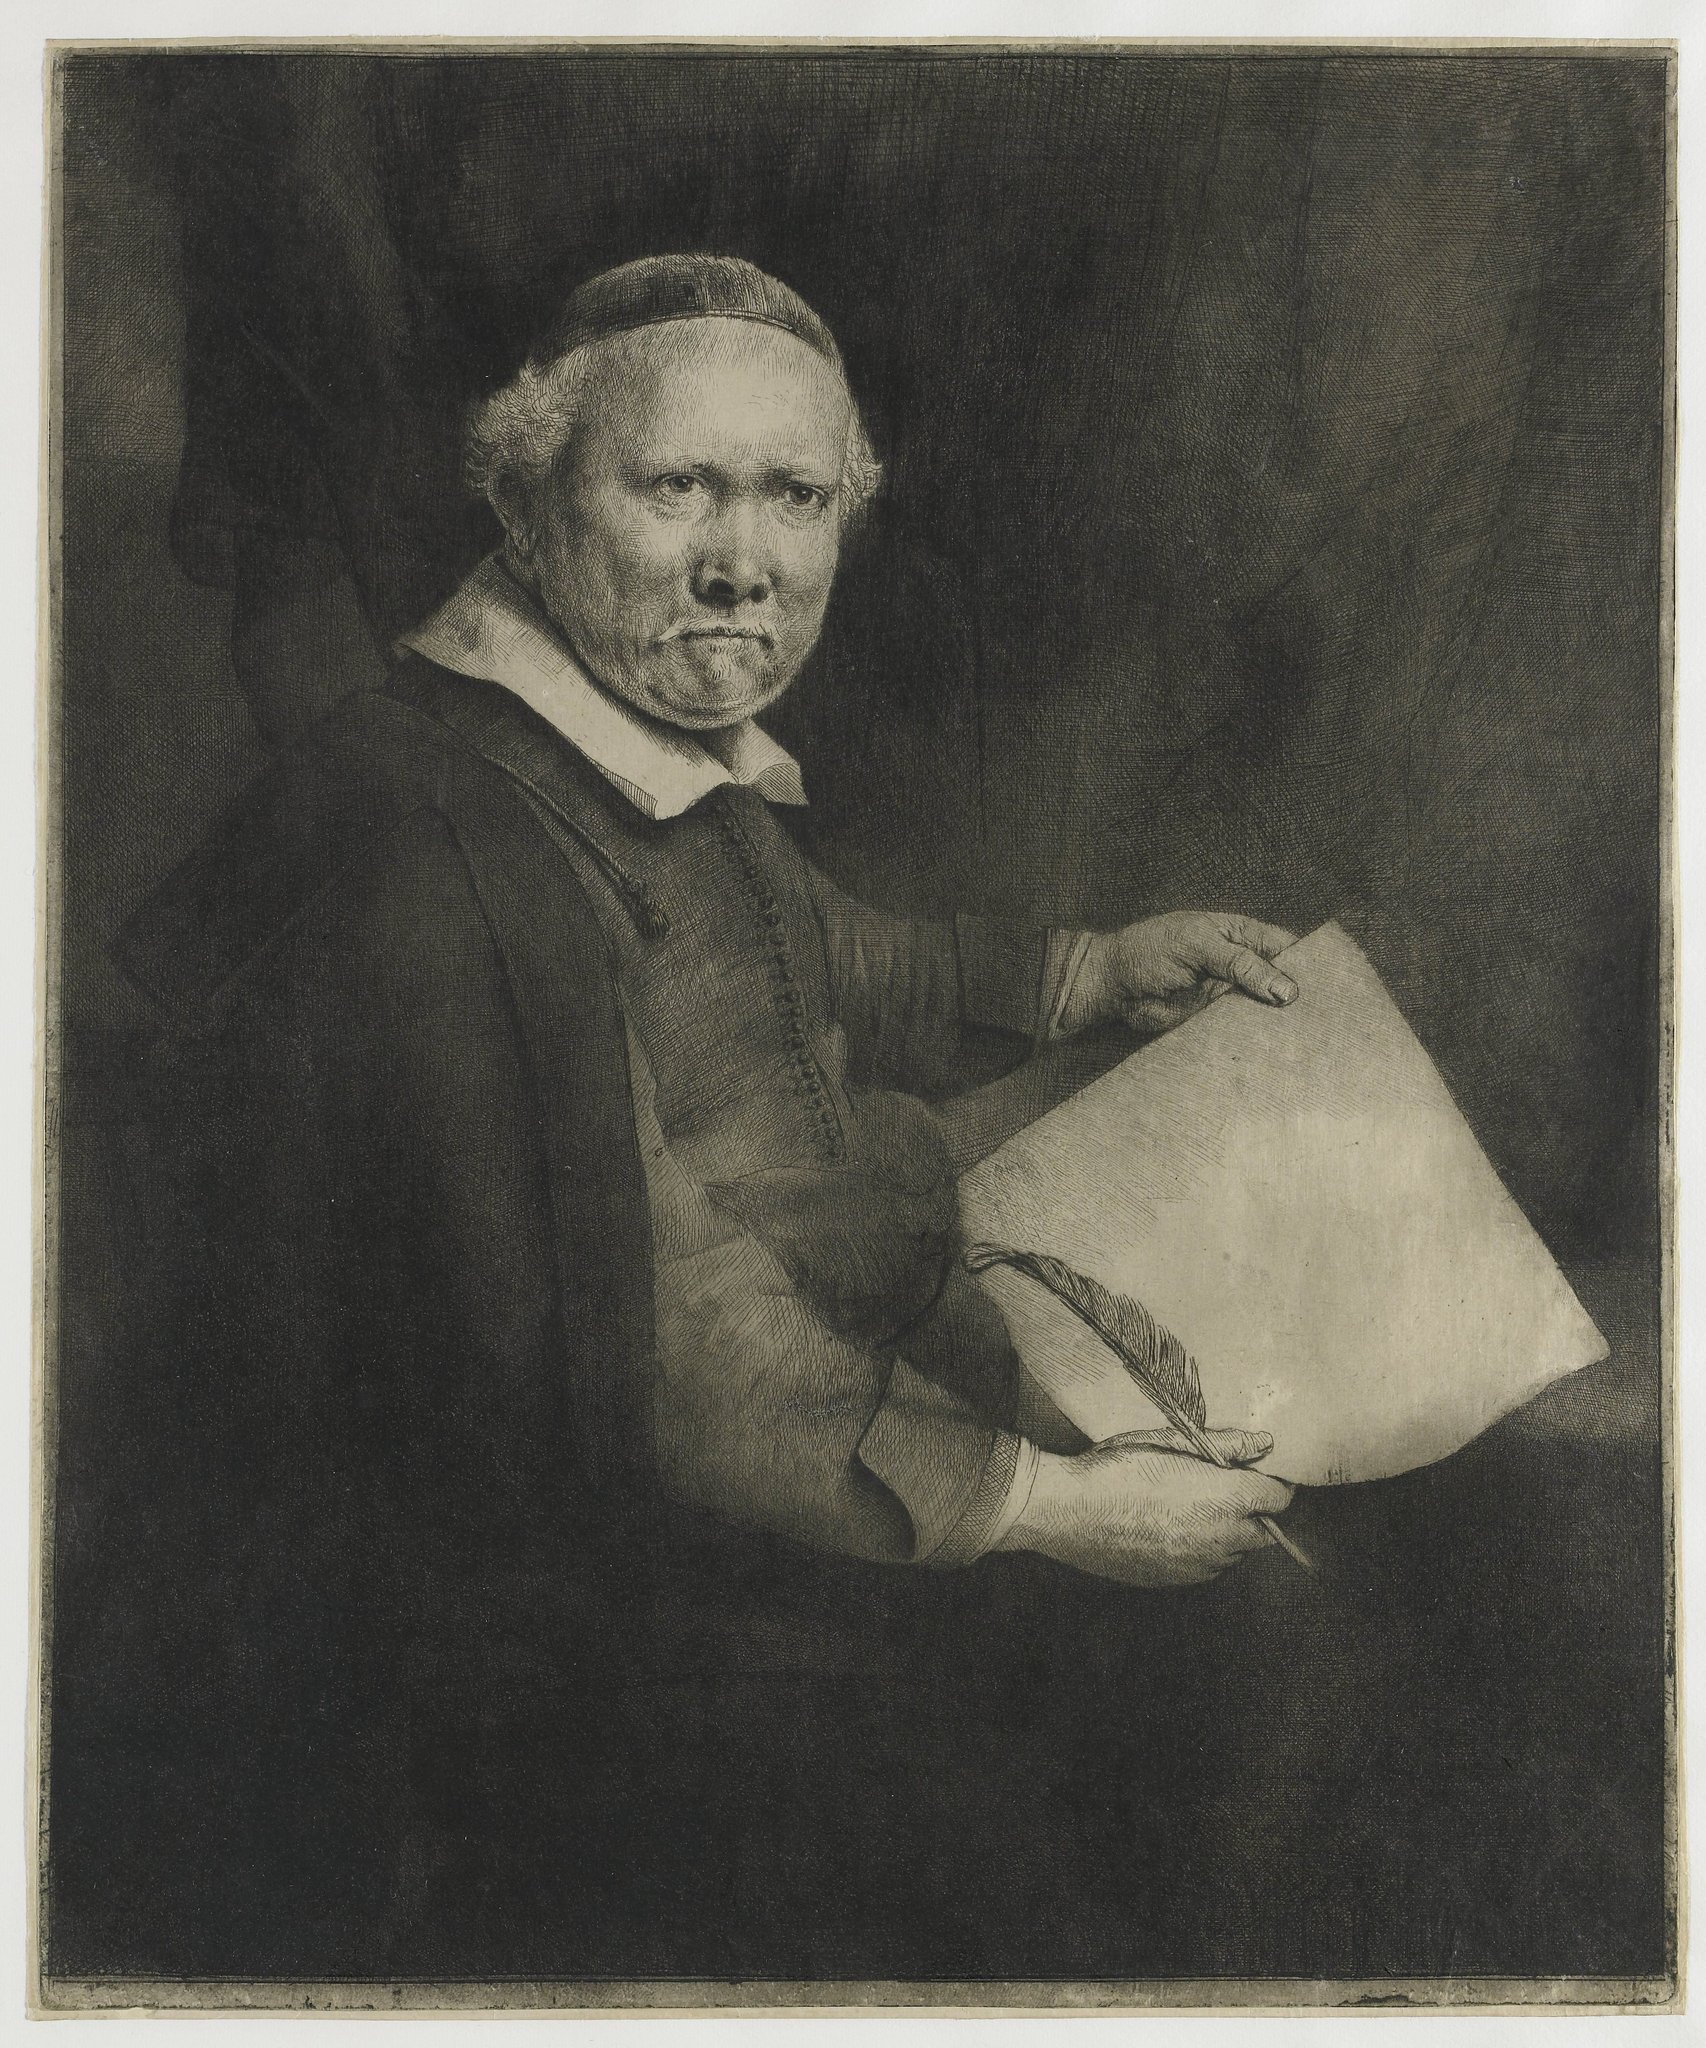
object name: print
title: Lieven Willemsz. van Coppenol, writing master: the larger plate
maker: rembrandt van rijn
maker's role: draughtsman, painter, print maker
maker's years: 1606-1669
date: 1658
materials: paper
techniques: drypoint, etching, intaglio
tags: lieven willemsz. coppenol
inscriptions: collector's mark: Lugt 240